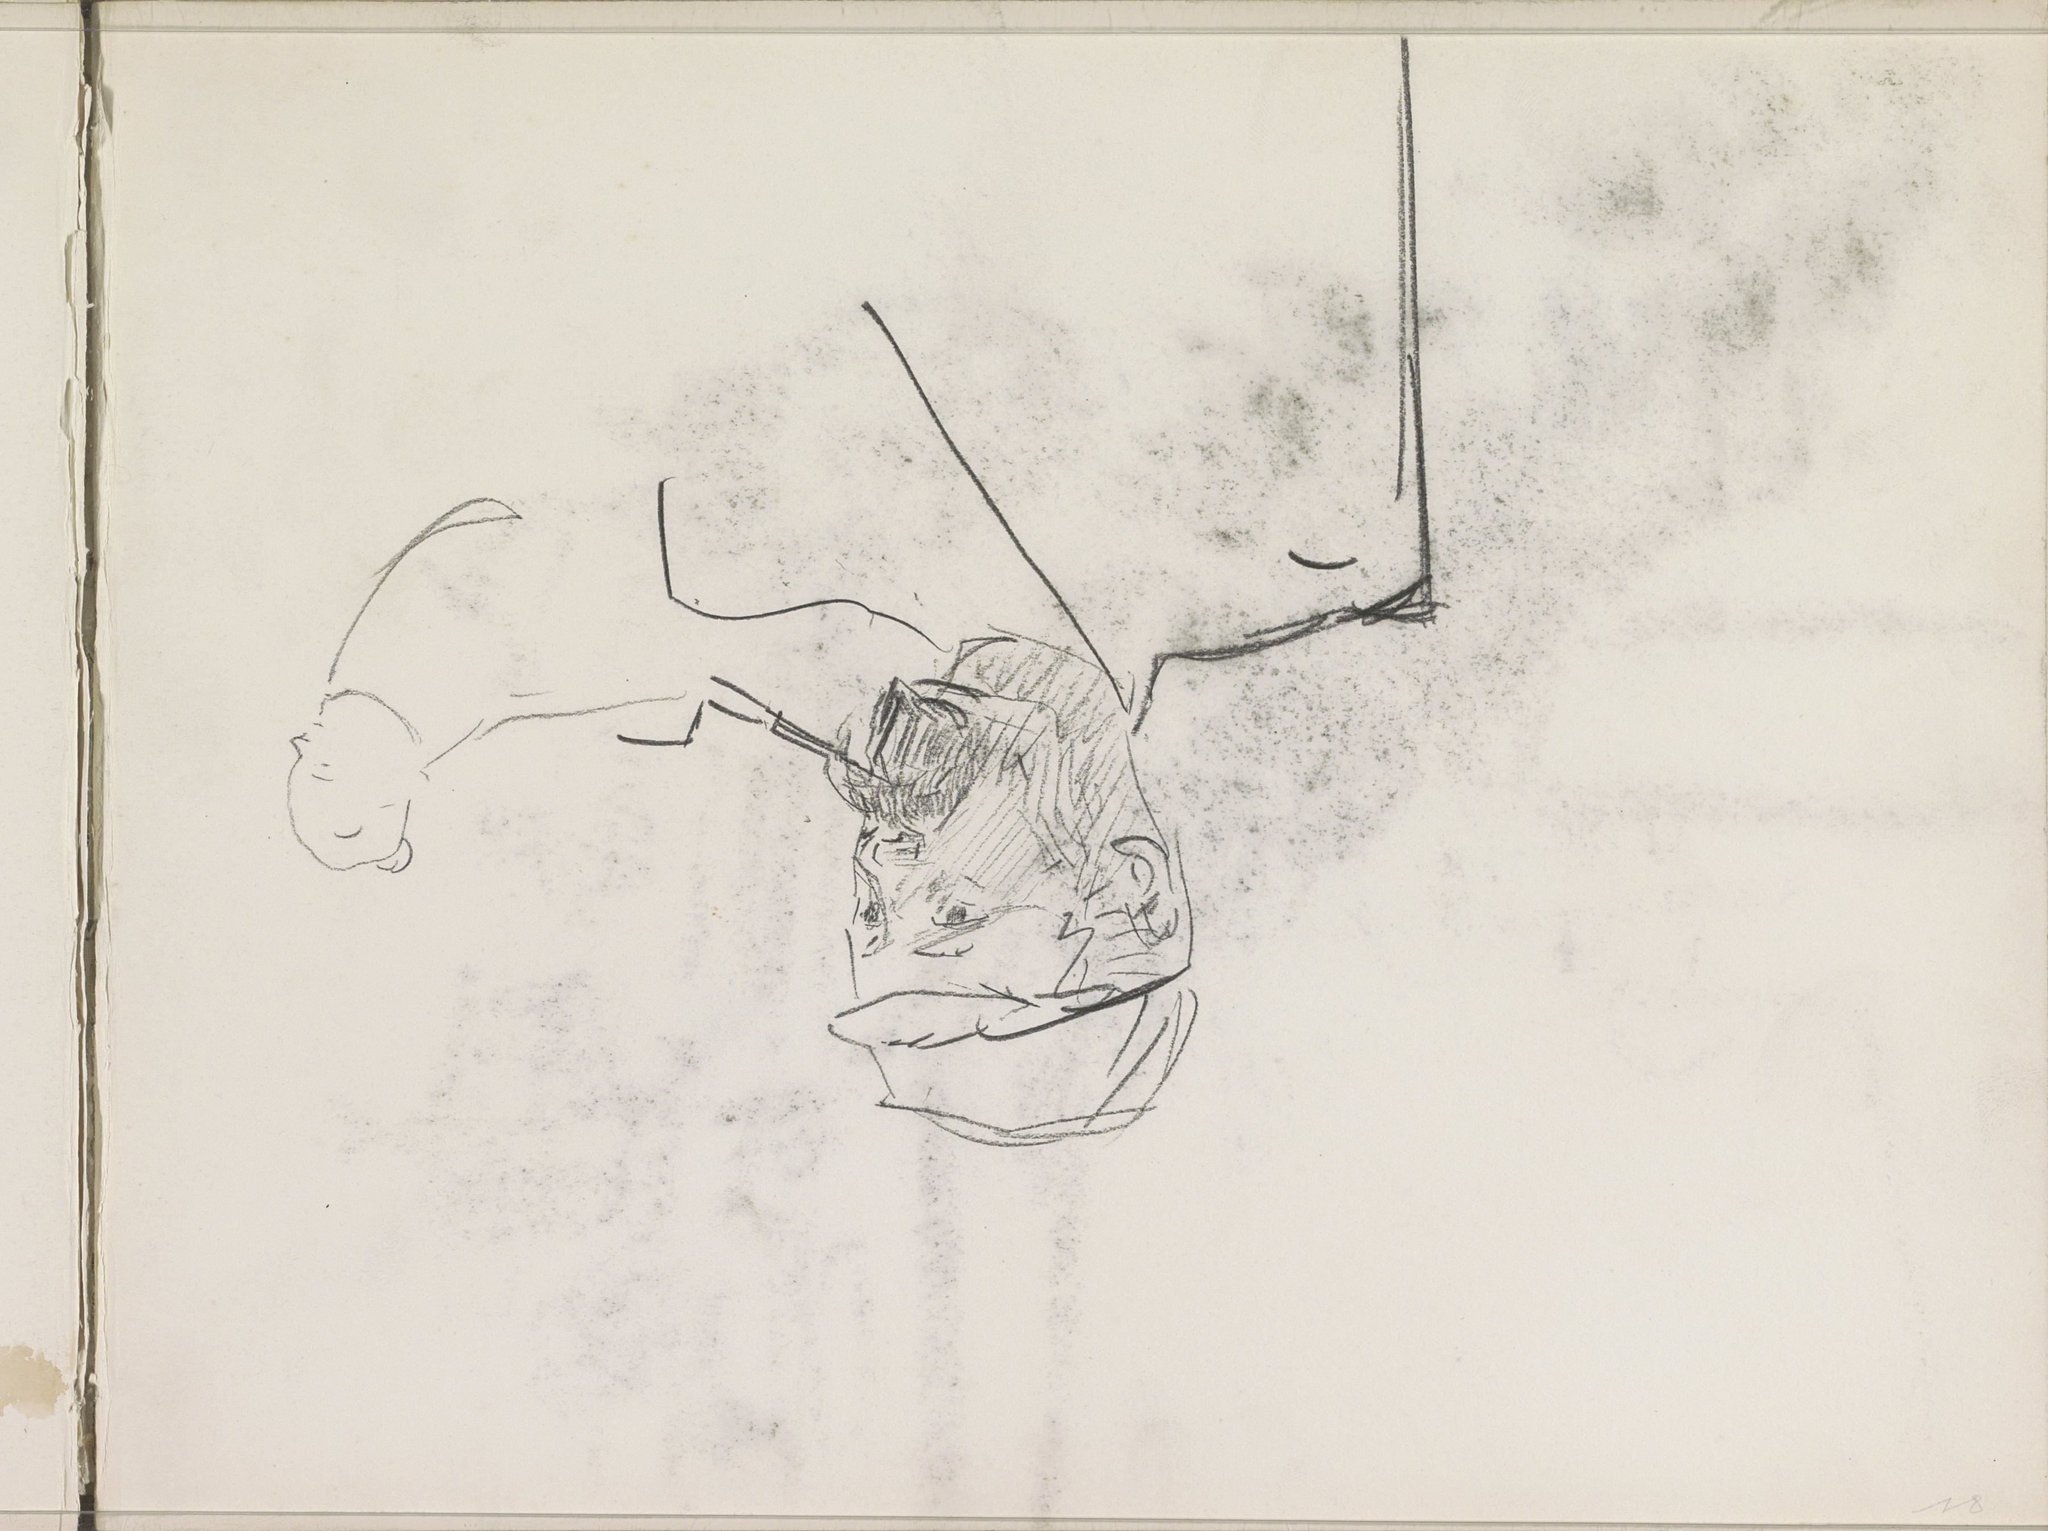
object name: sketchbook leaf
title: Rokende man met pet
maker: isaac israels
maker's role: draughtsman, painter, print maker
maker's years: 1865-1934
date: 1875-1934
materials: chalk, paper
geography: the hague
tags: animal traction, animal-drawn vehicle (carriage etc.), tobacco (+ taking (particular) foodstuffs: eating, drinking, smoking, chewing, etc.)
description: Blad 18 recto uit schetsboek VII met 26 bladen.